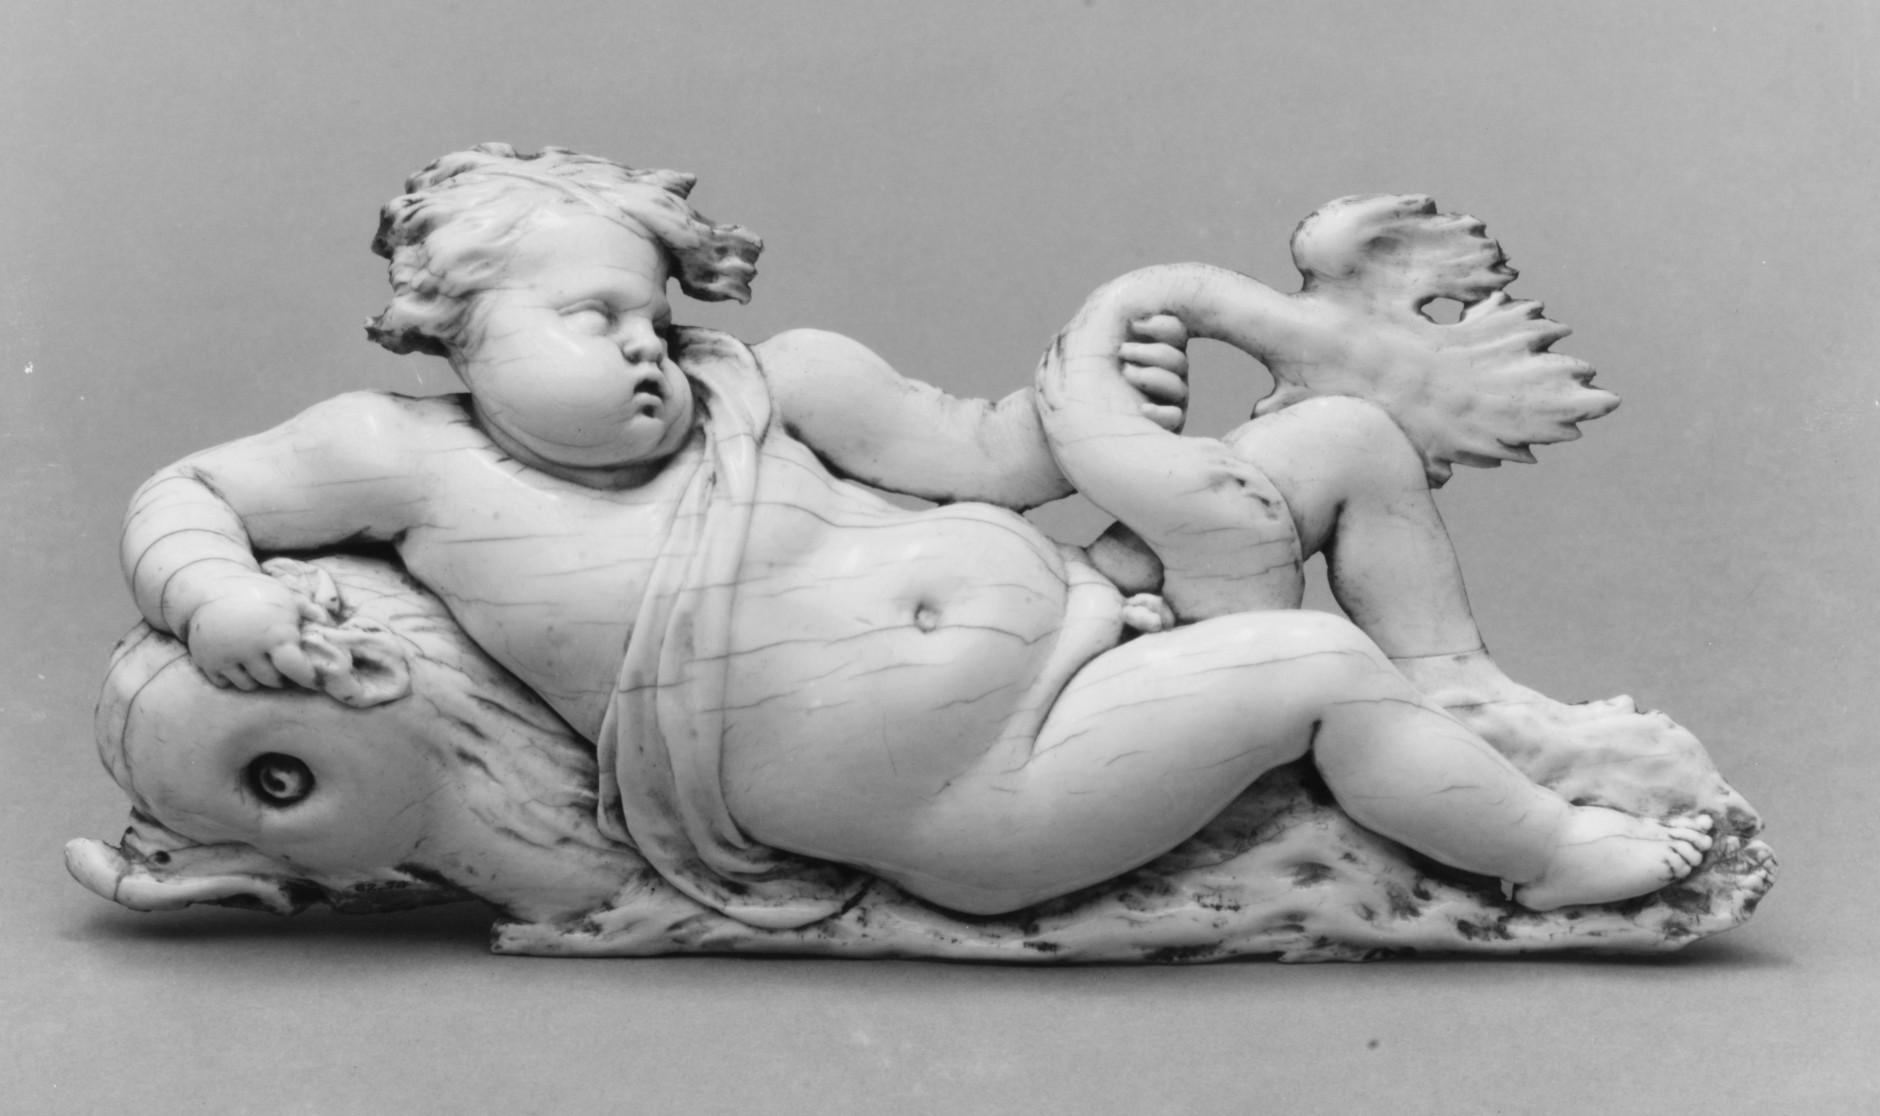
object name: relief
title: Putto on a Dolphin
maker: gerard van opstal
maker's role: artist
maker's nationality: flemish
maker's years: 1597-1668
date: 1634-1666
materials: ivory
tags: putti,dolphins